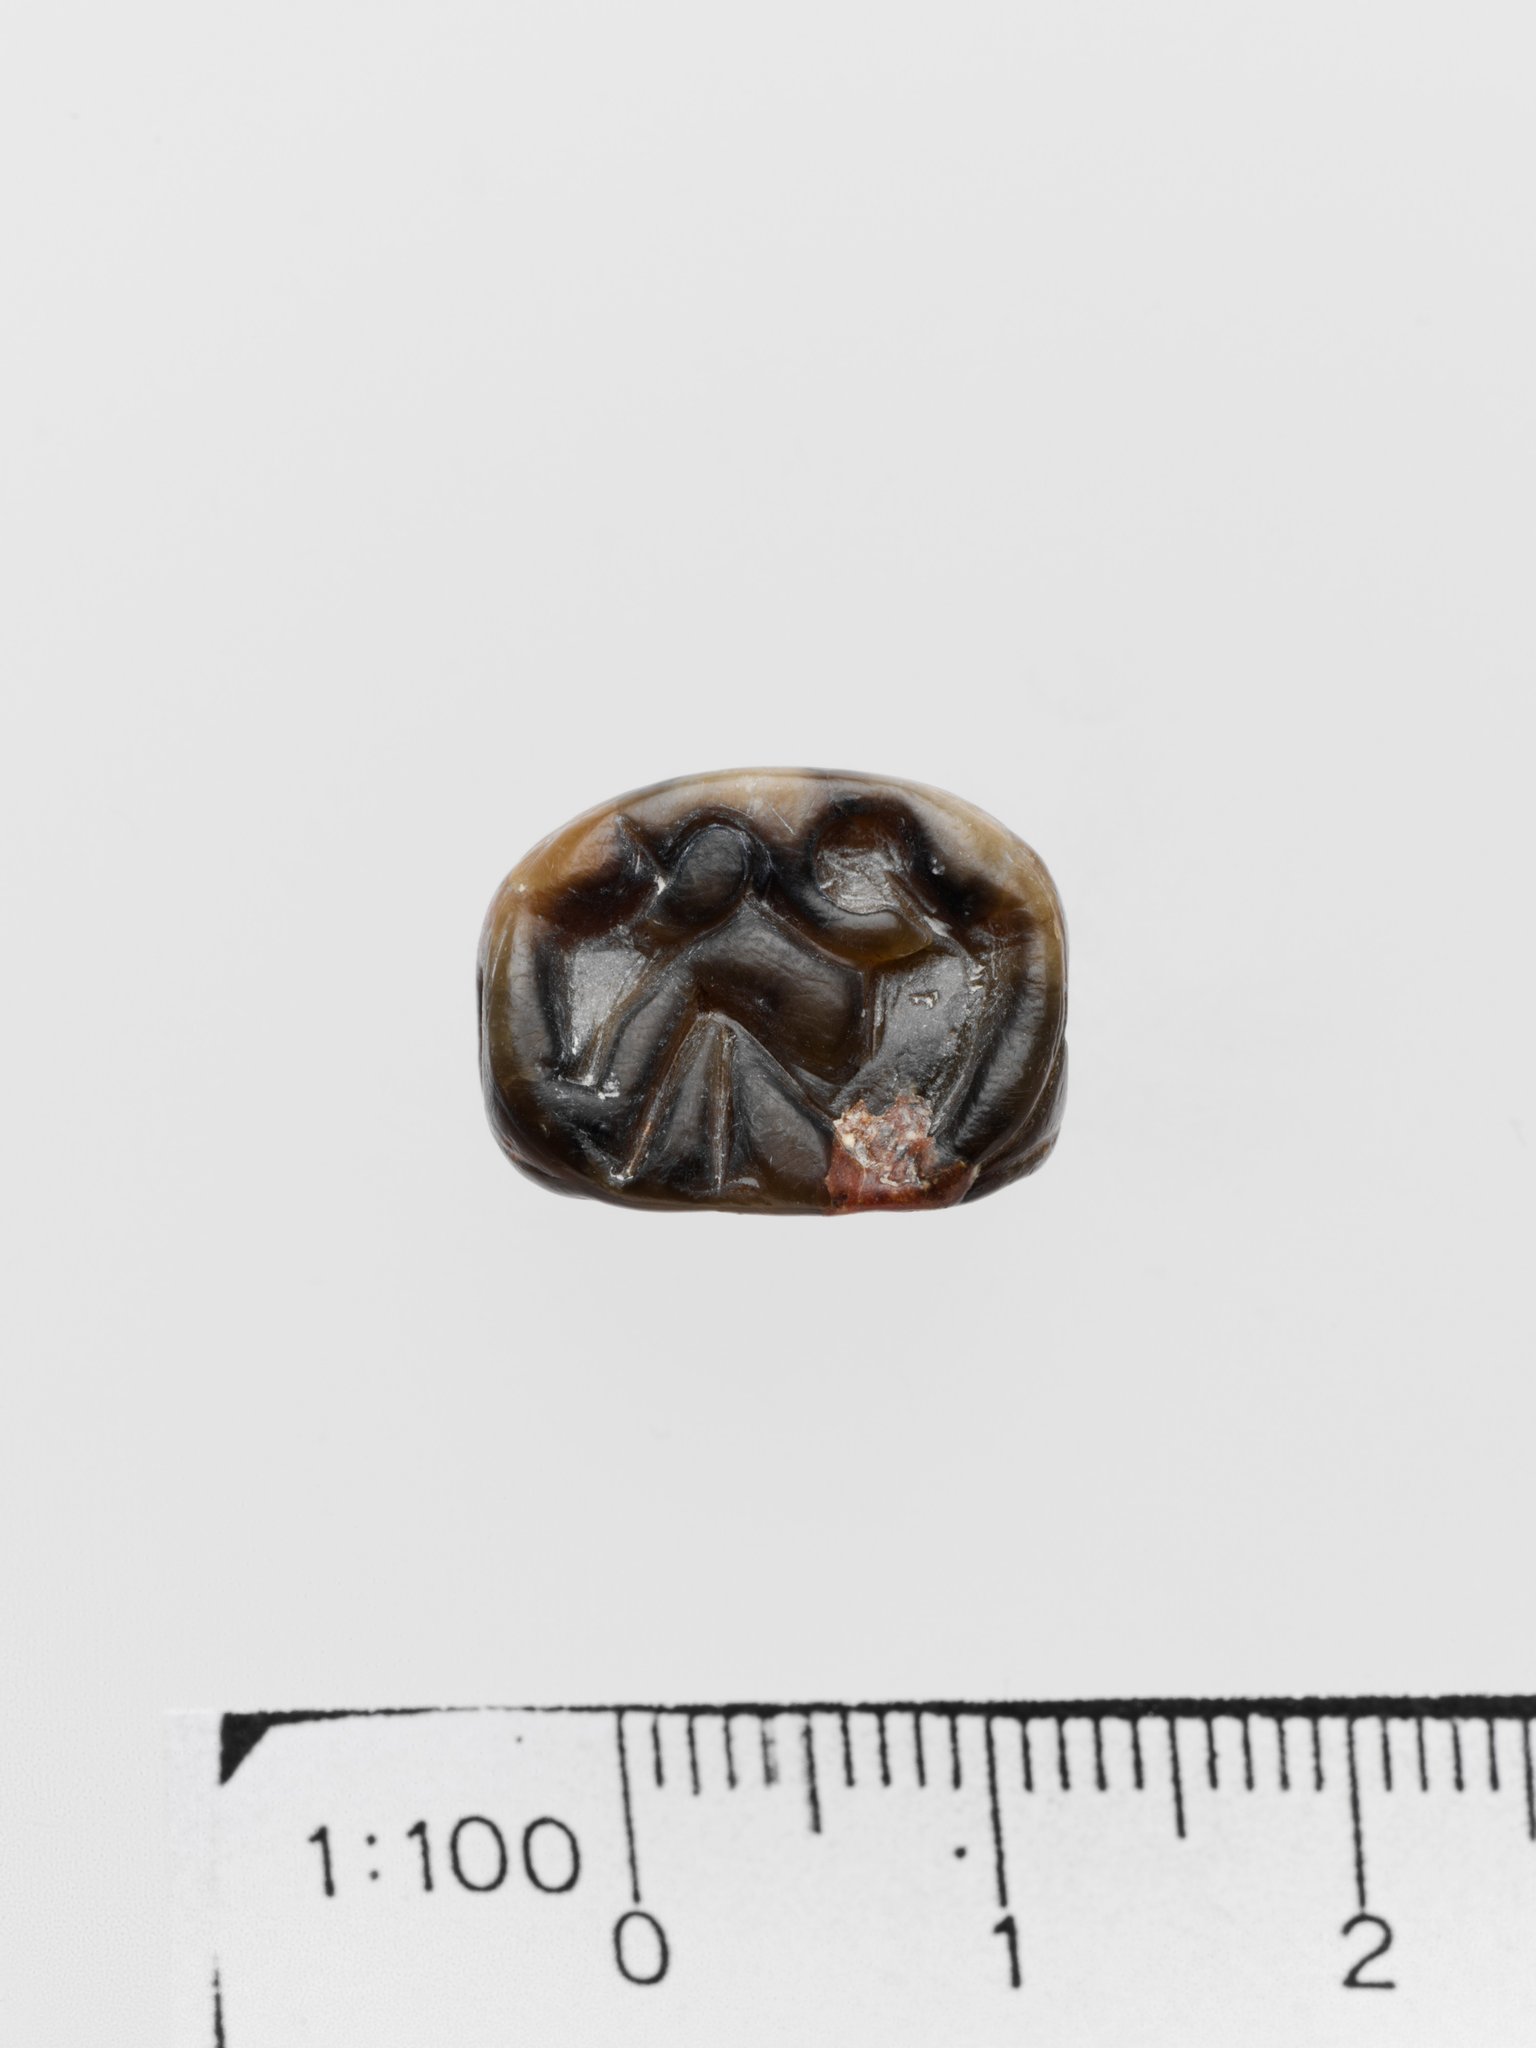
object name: prism, triangular seal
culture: minoan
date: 1800-1700 BCE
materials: stone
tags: men,goats